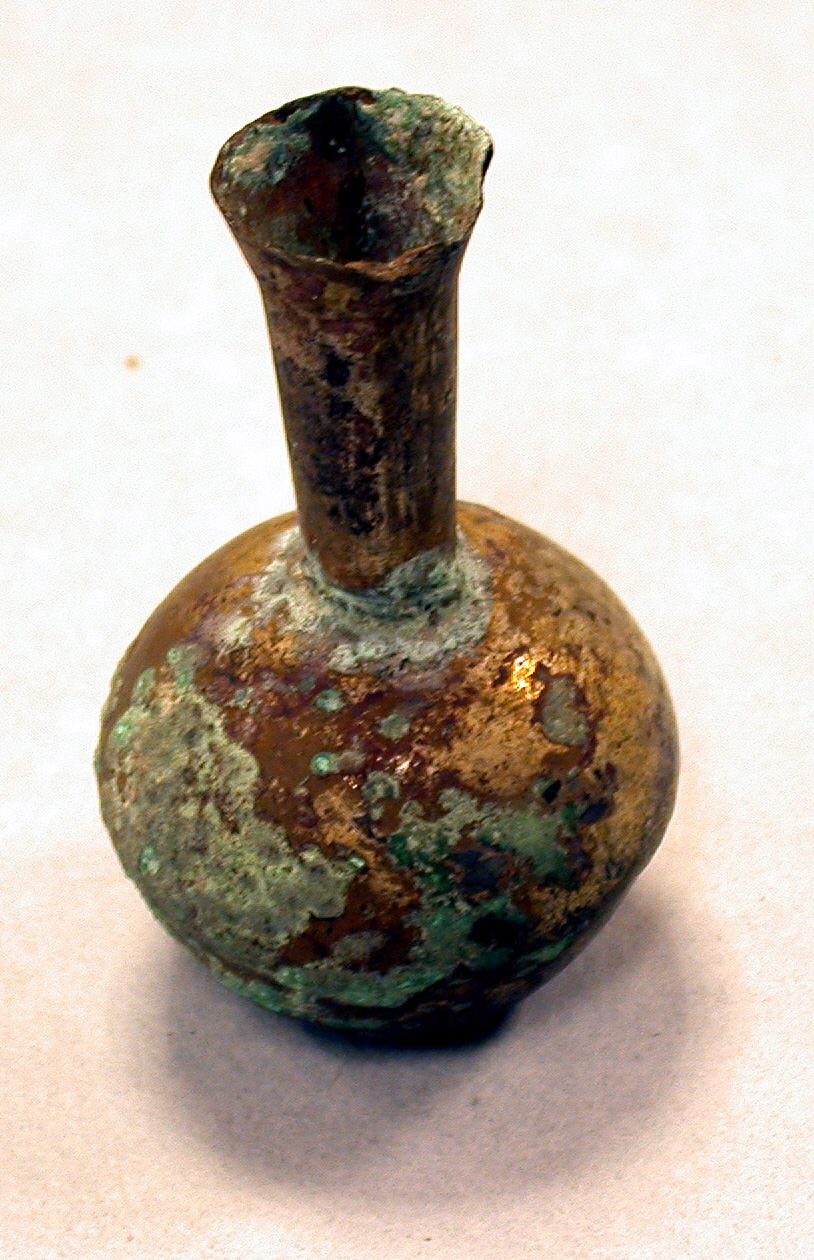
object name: bottle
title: Miniature Bottle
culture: chancay or chimú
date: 1001-1500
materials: copper, silver gilt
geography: peru